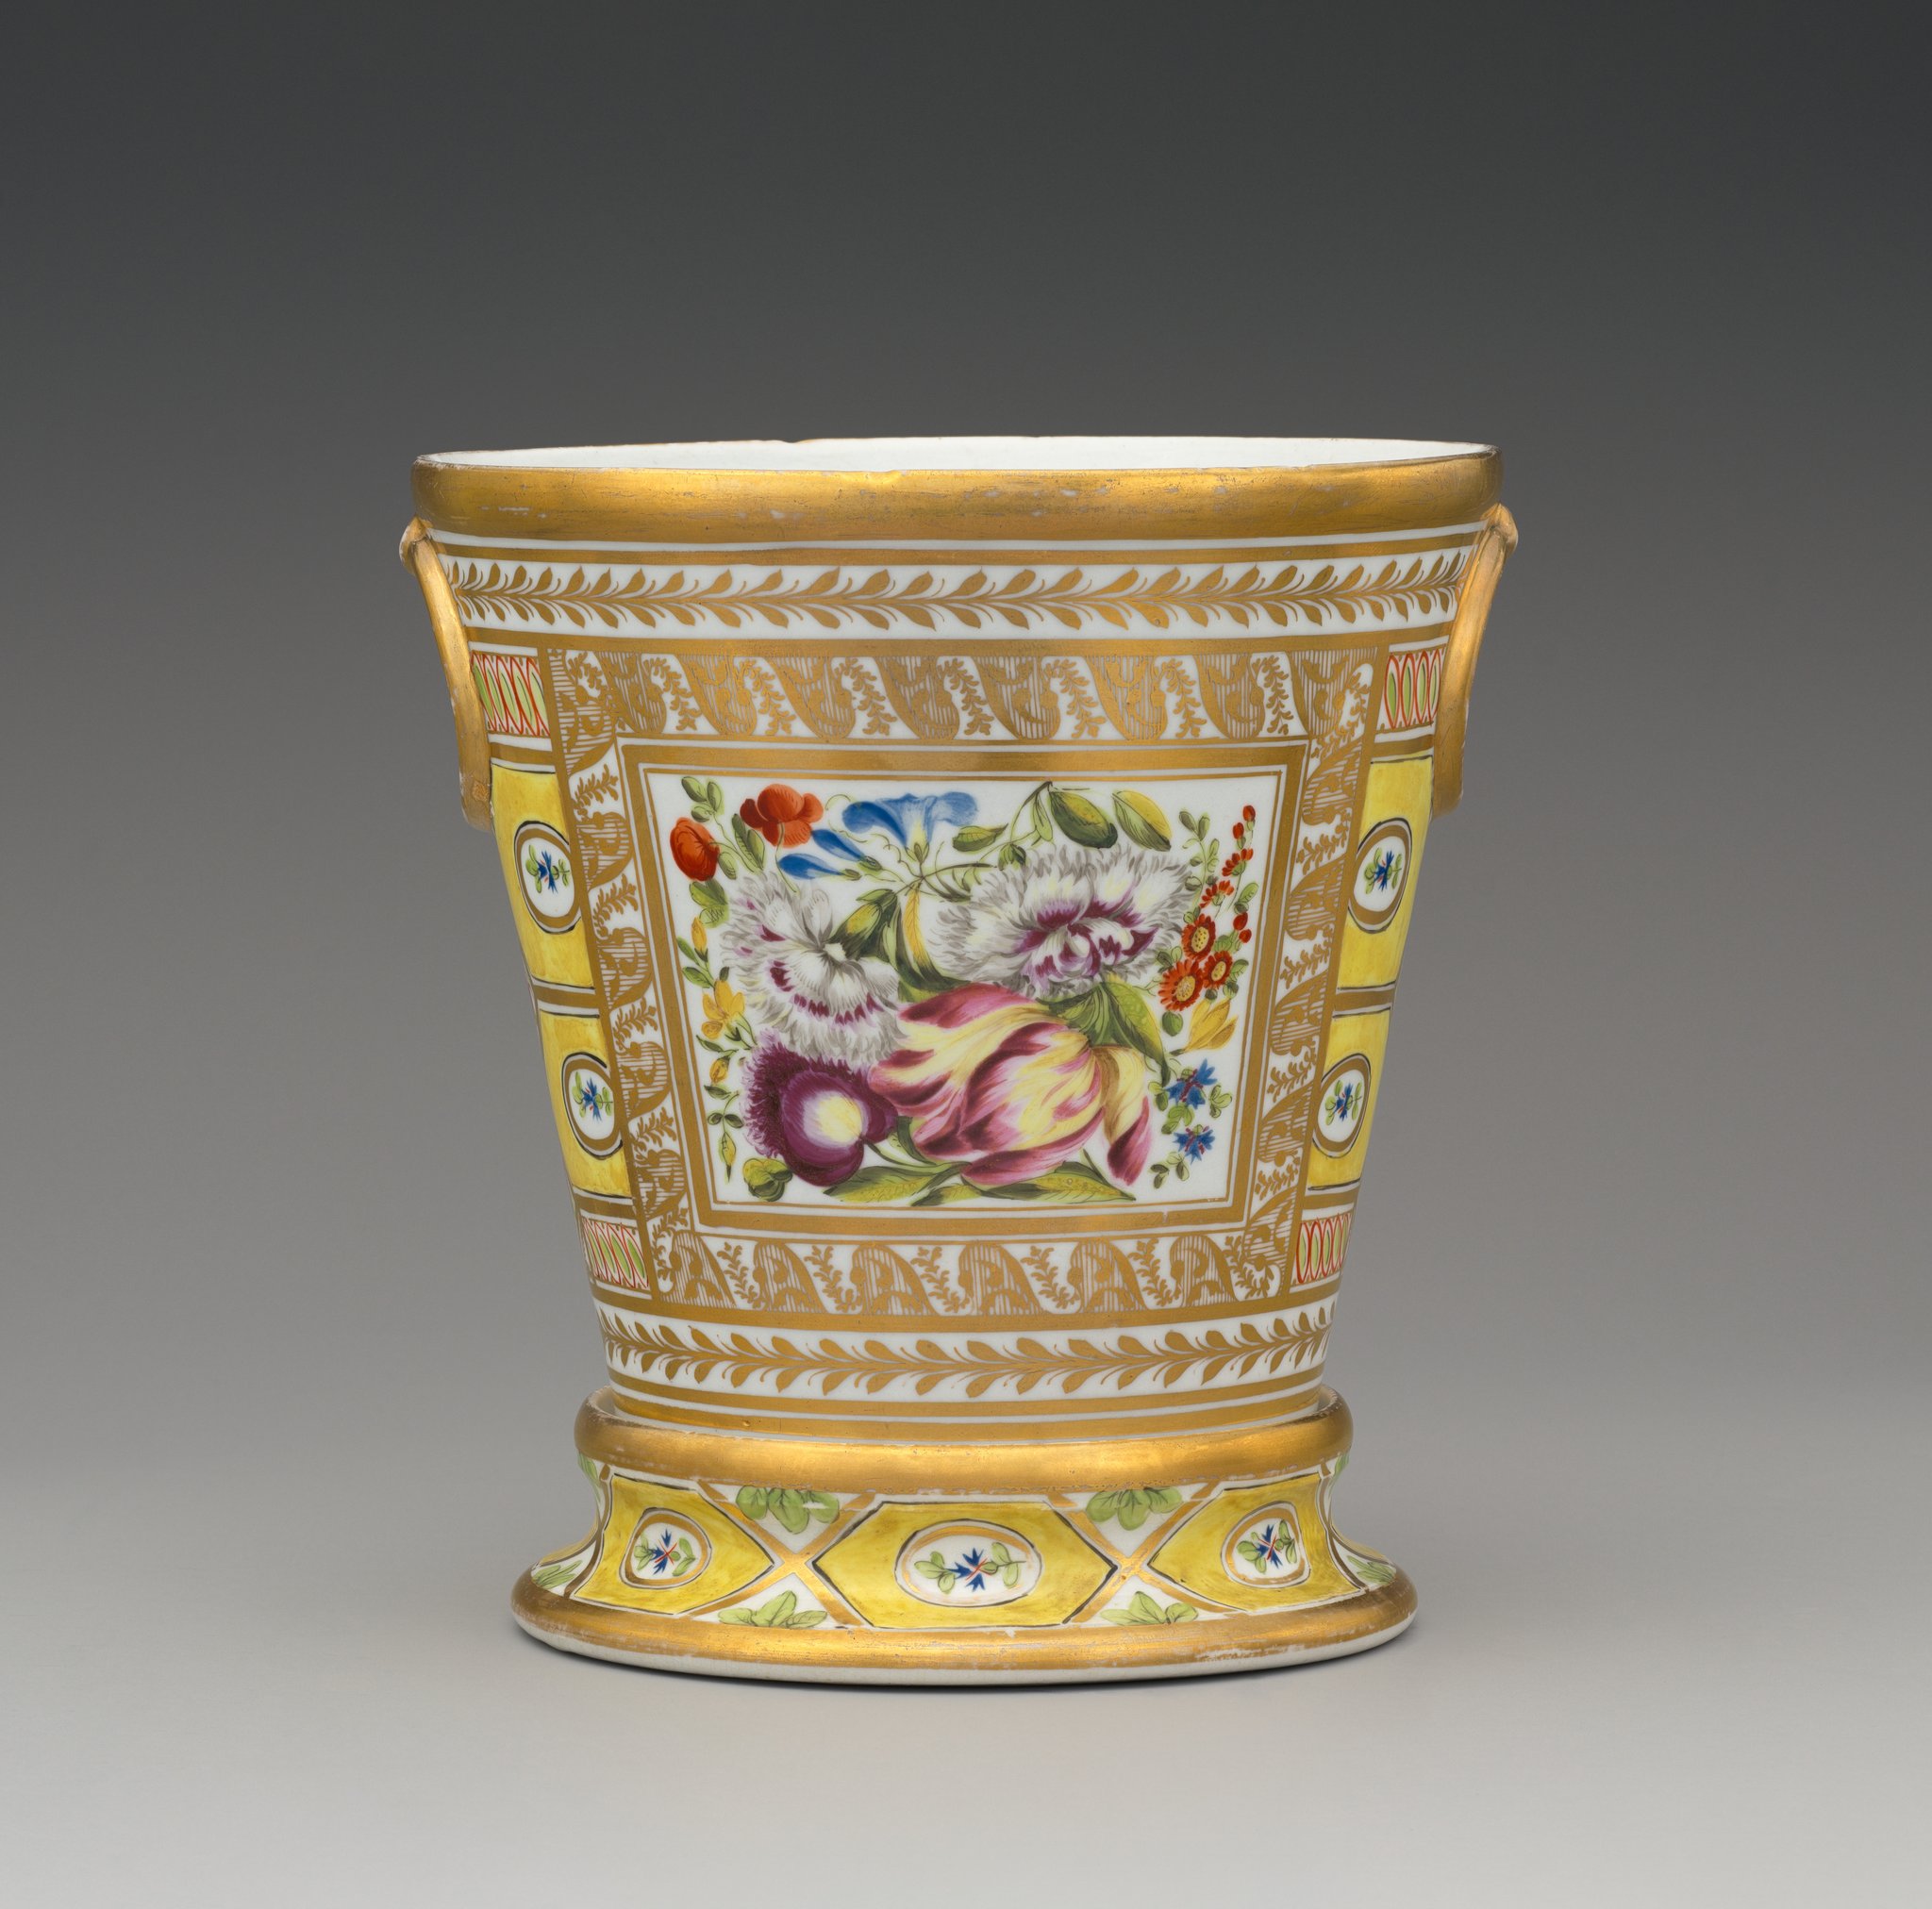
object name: cachepot with stand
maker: coalport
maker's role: factory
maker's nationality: british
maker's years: 1794-1926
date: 1805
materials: soft paste porcelain